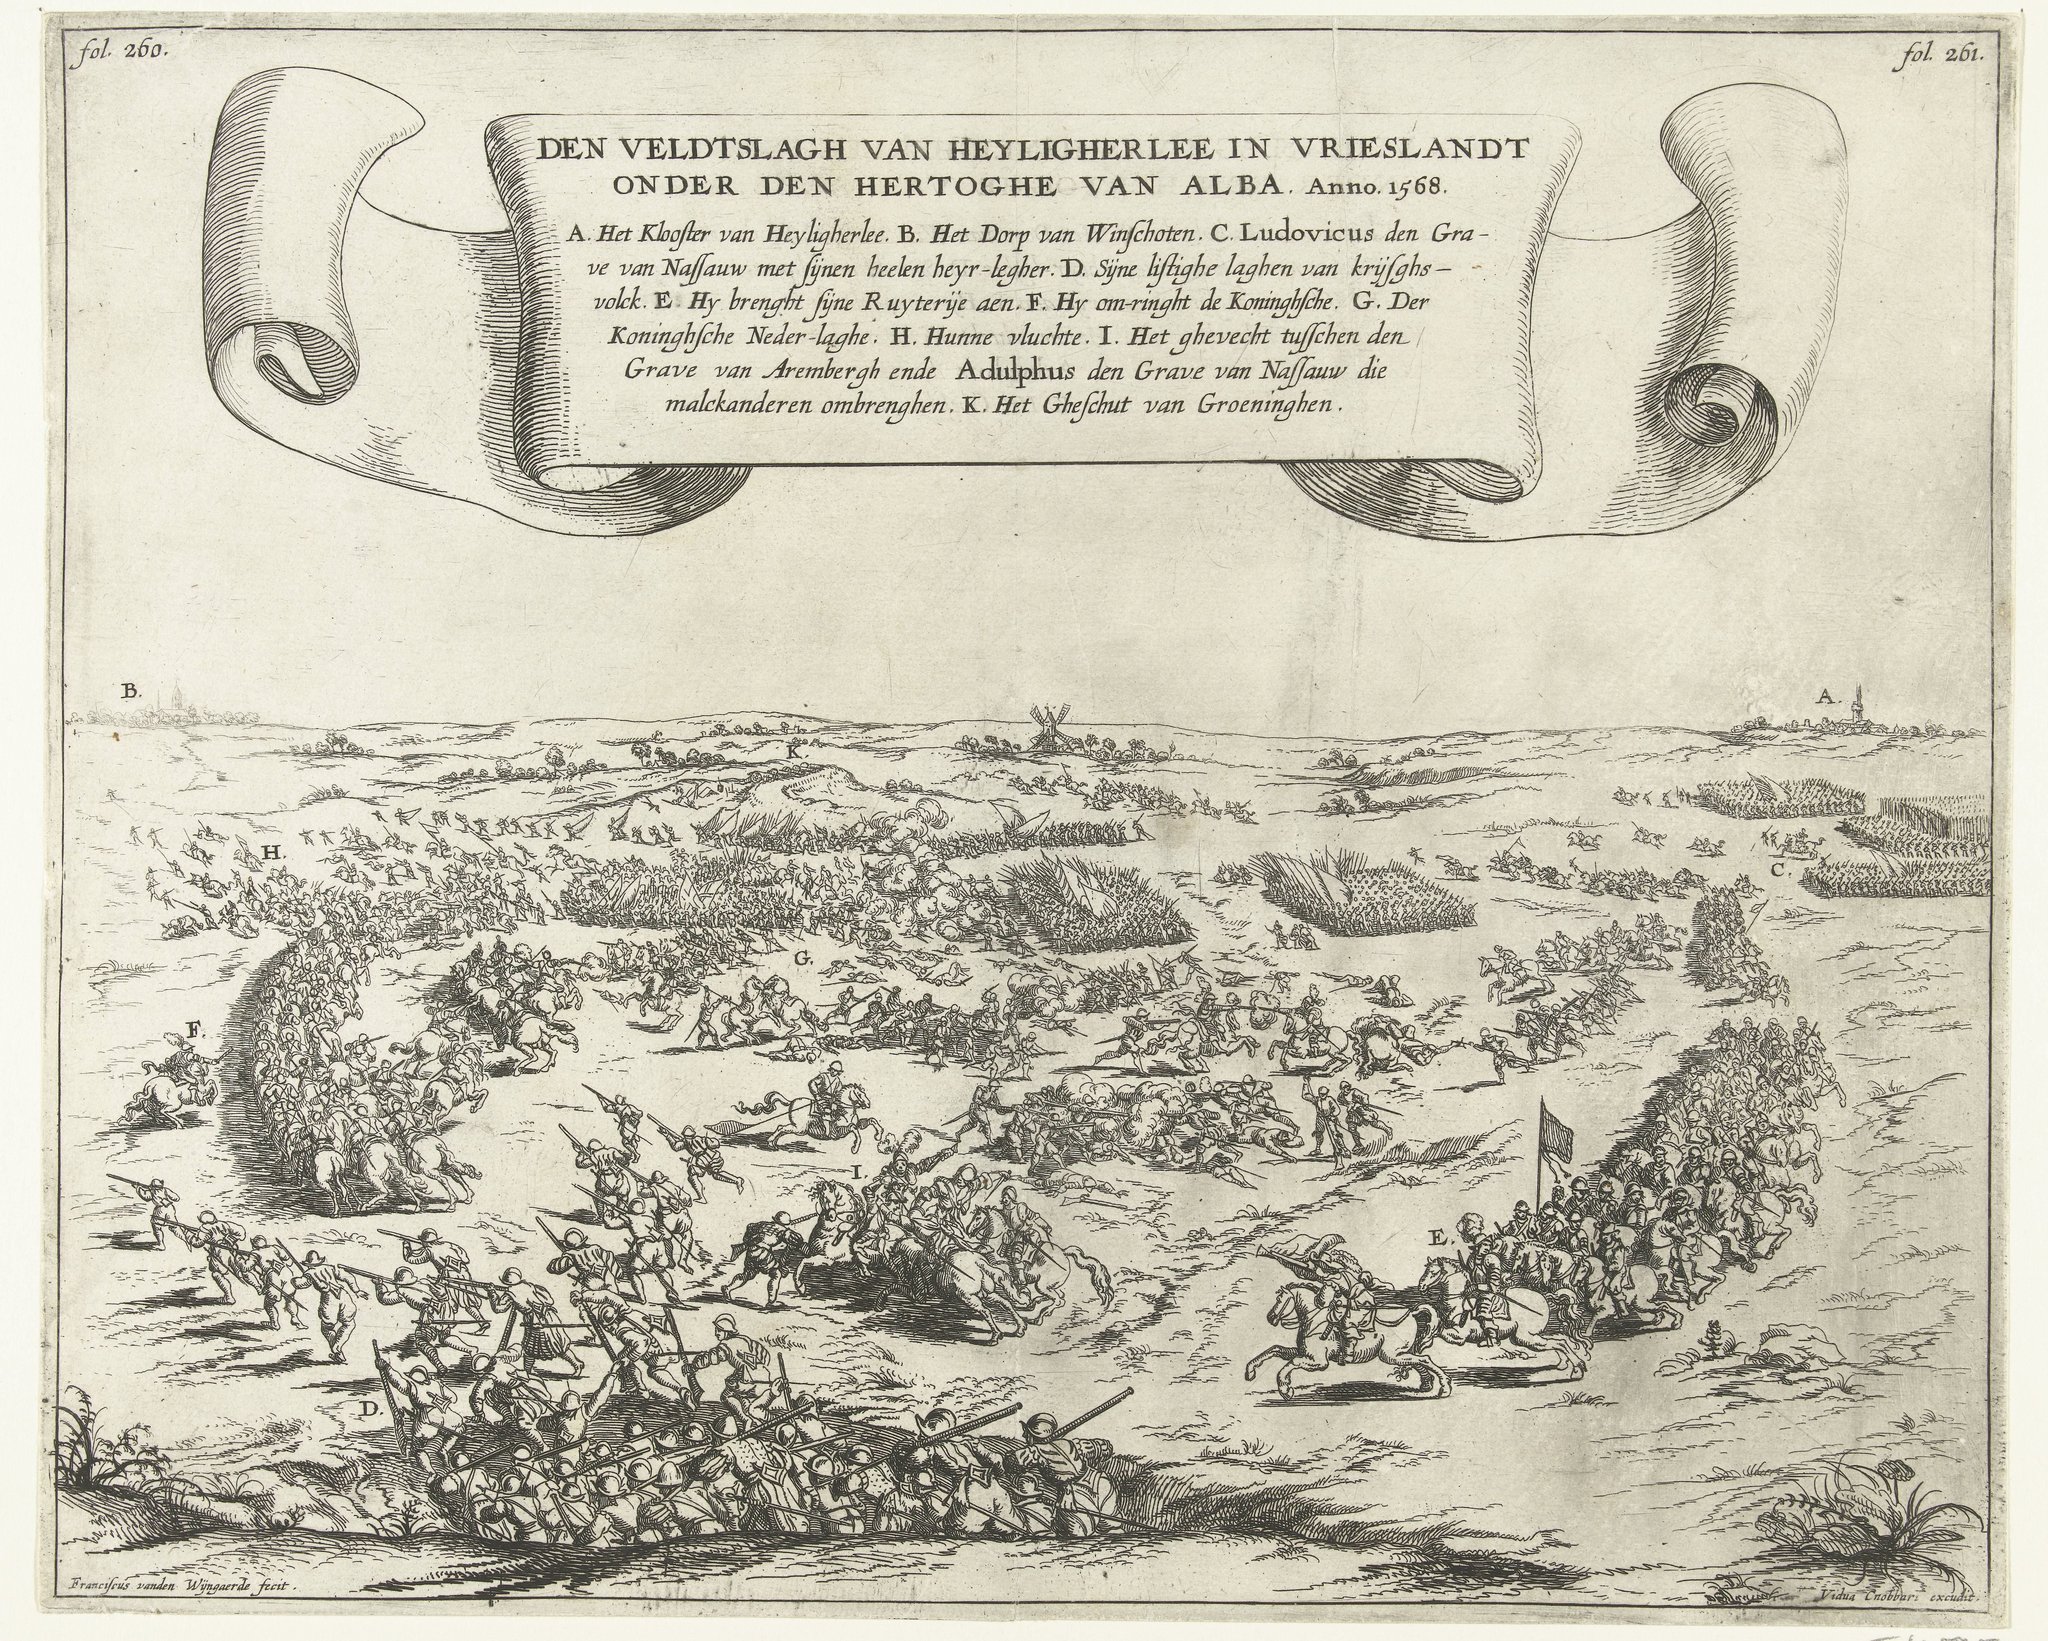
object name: print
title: Den veldtslagh van Heyligherlee in Vrieslandt onder den hertoghe van Alba. Anno 1568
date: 1643-1645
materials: paper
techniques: etching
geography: germany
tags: jean de ligne (duke of arenberg), battle (+ land forces)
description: Slag bij Heiligerlee, 23 mei 1568. Gezicht op het slagveld, in het midden het sneuvelen van graaf Adolf en de graaf van Arenberg. Bovenin een banderol met de titel en legenda A-K in het Nederlands.